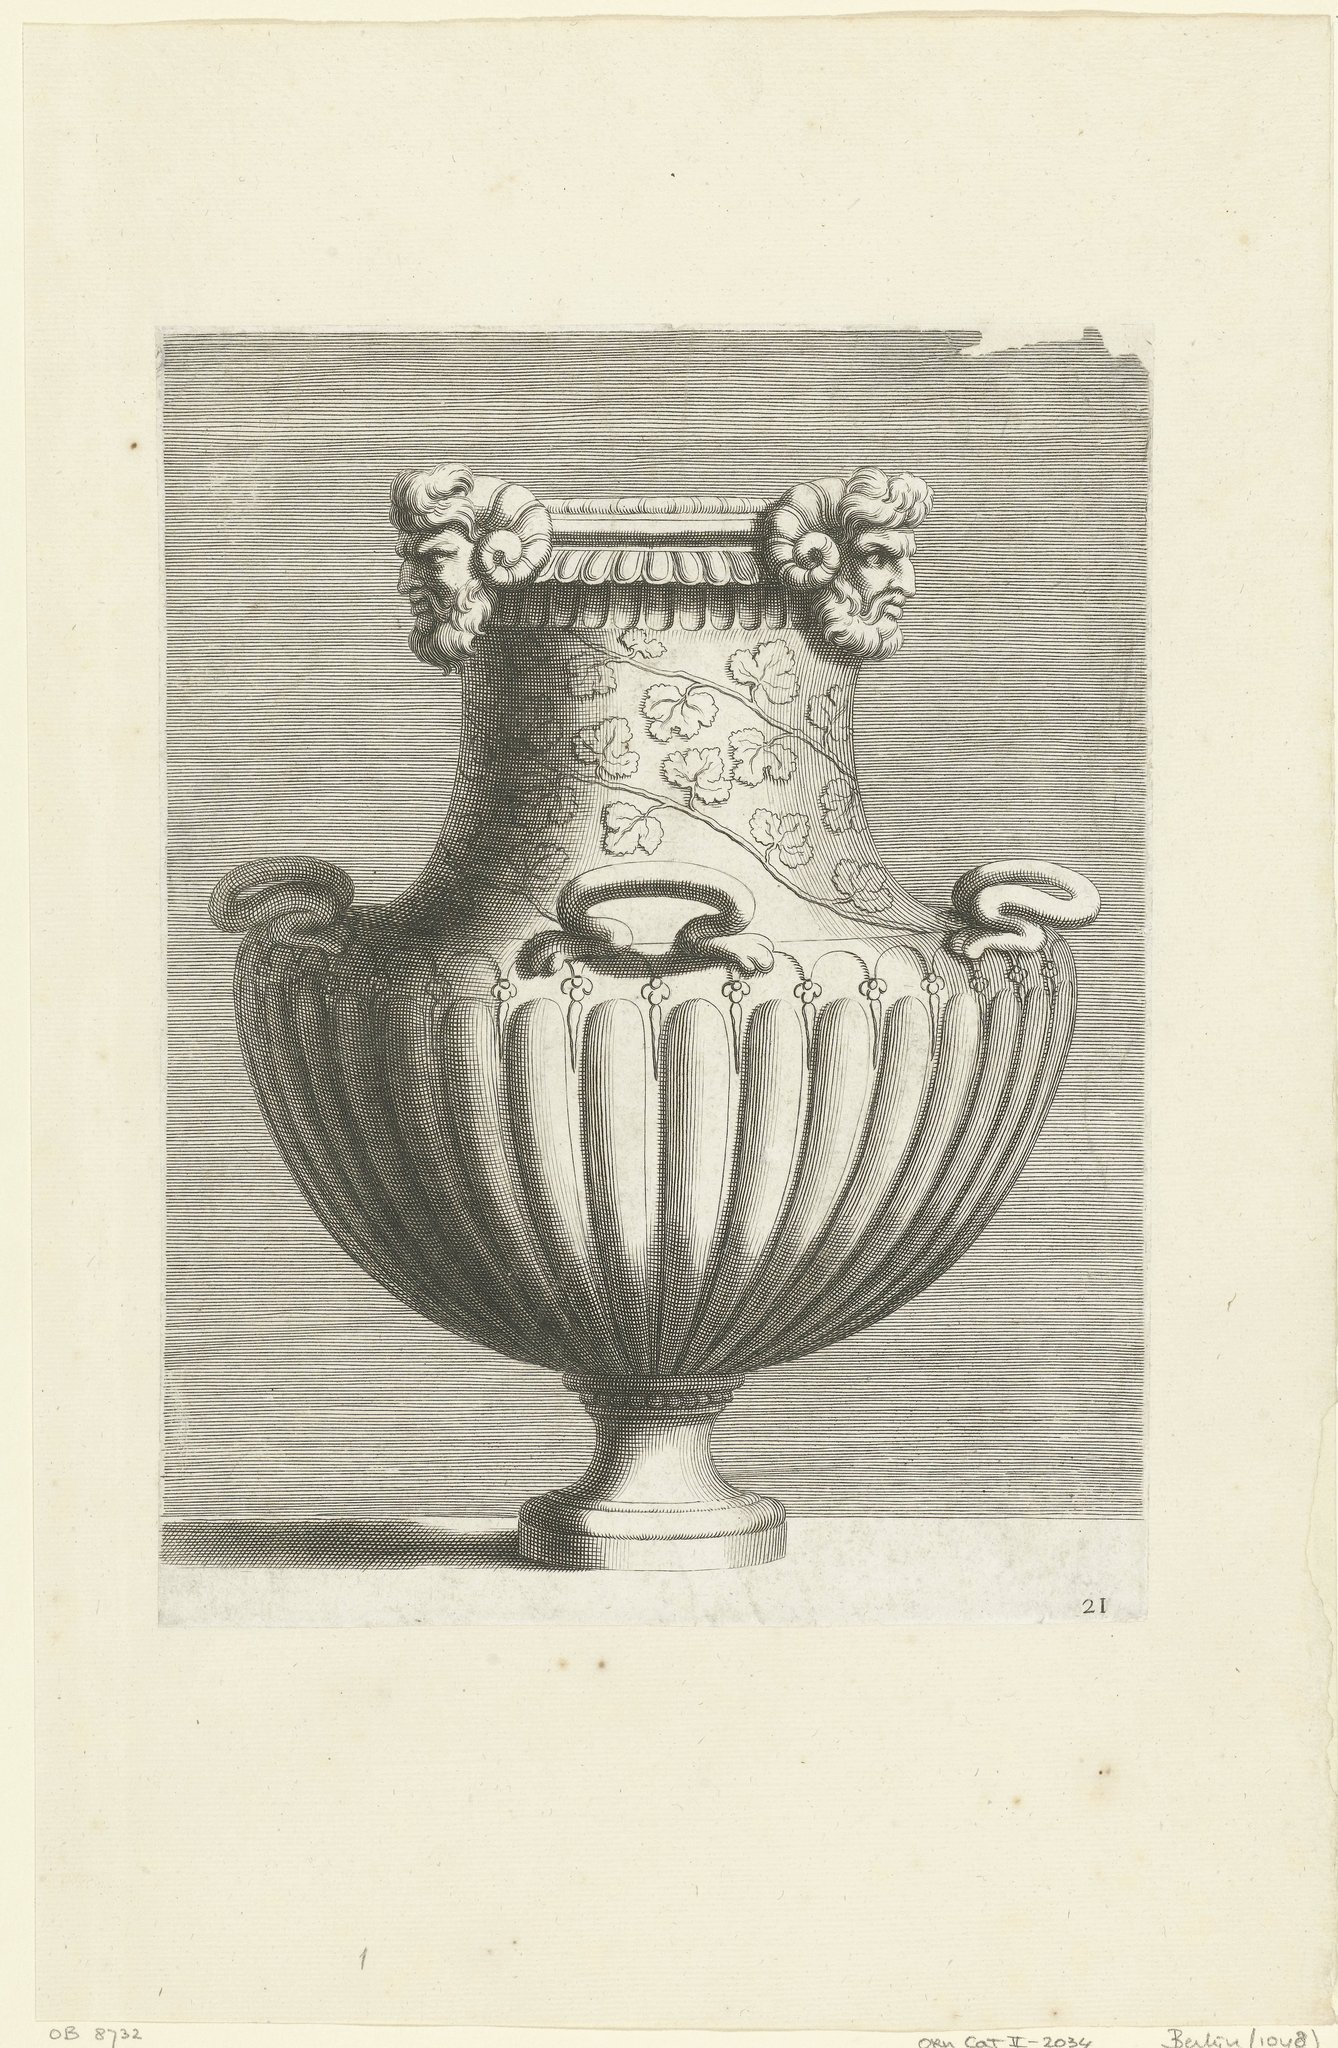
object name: ornament print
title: Vaas met twee saterhoofden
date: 1657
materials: paper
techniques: engraving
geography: france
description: De bovenkant is gedecoreerd met wijnranken. Blad 21 uit serie van 24 bladen, genummerd: 1-21, 23-25.